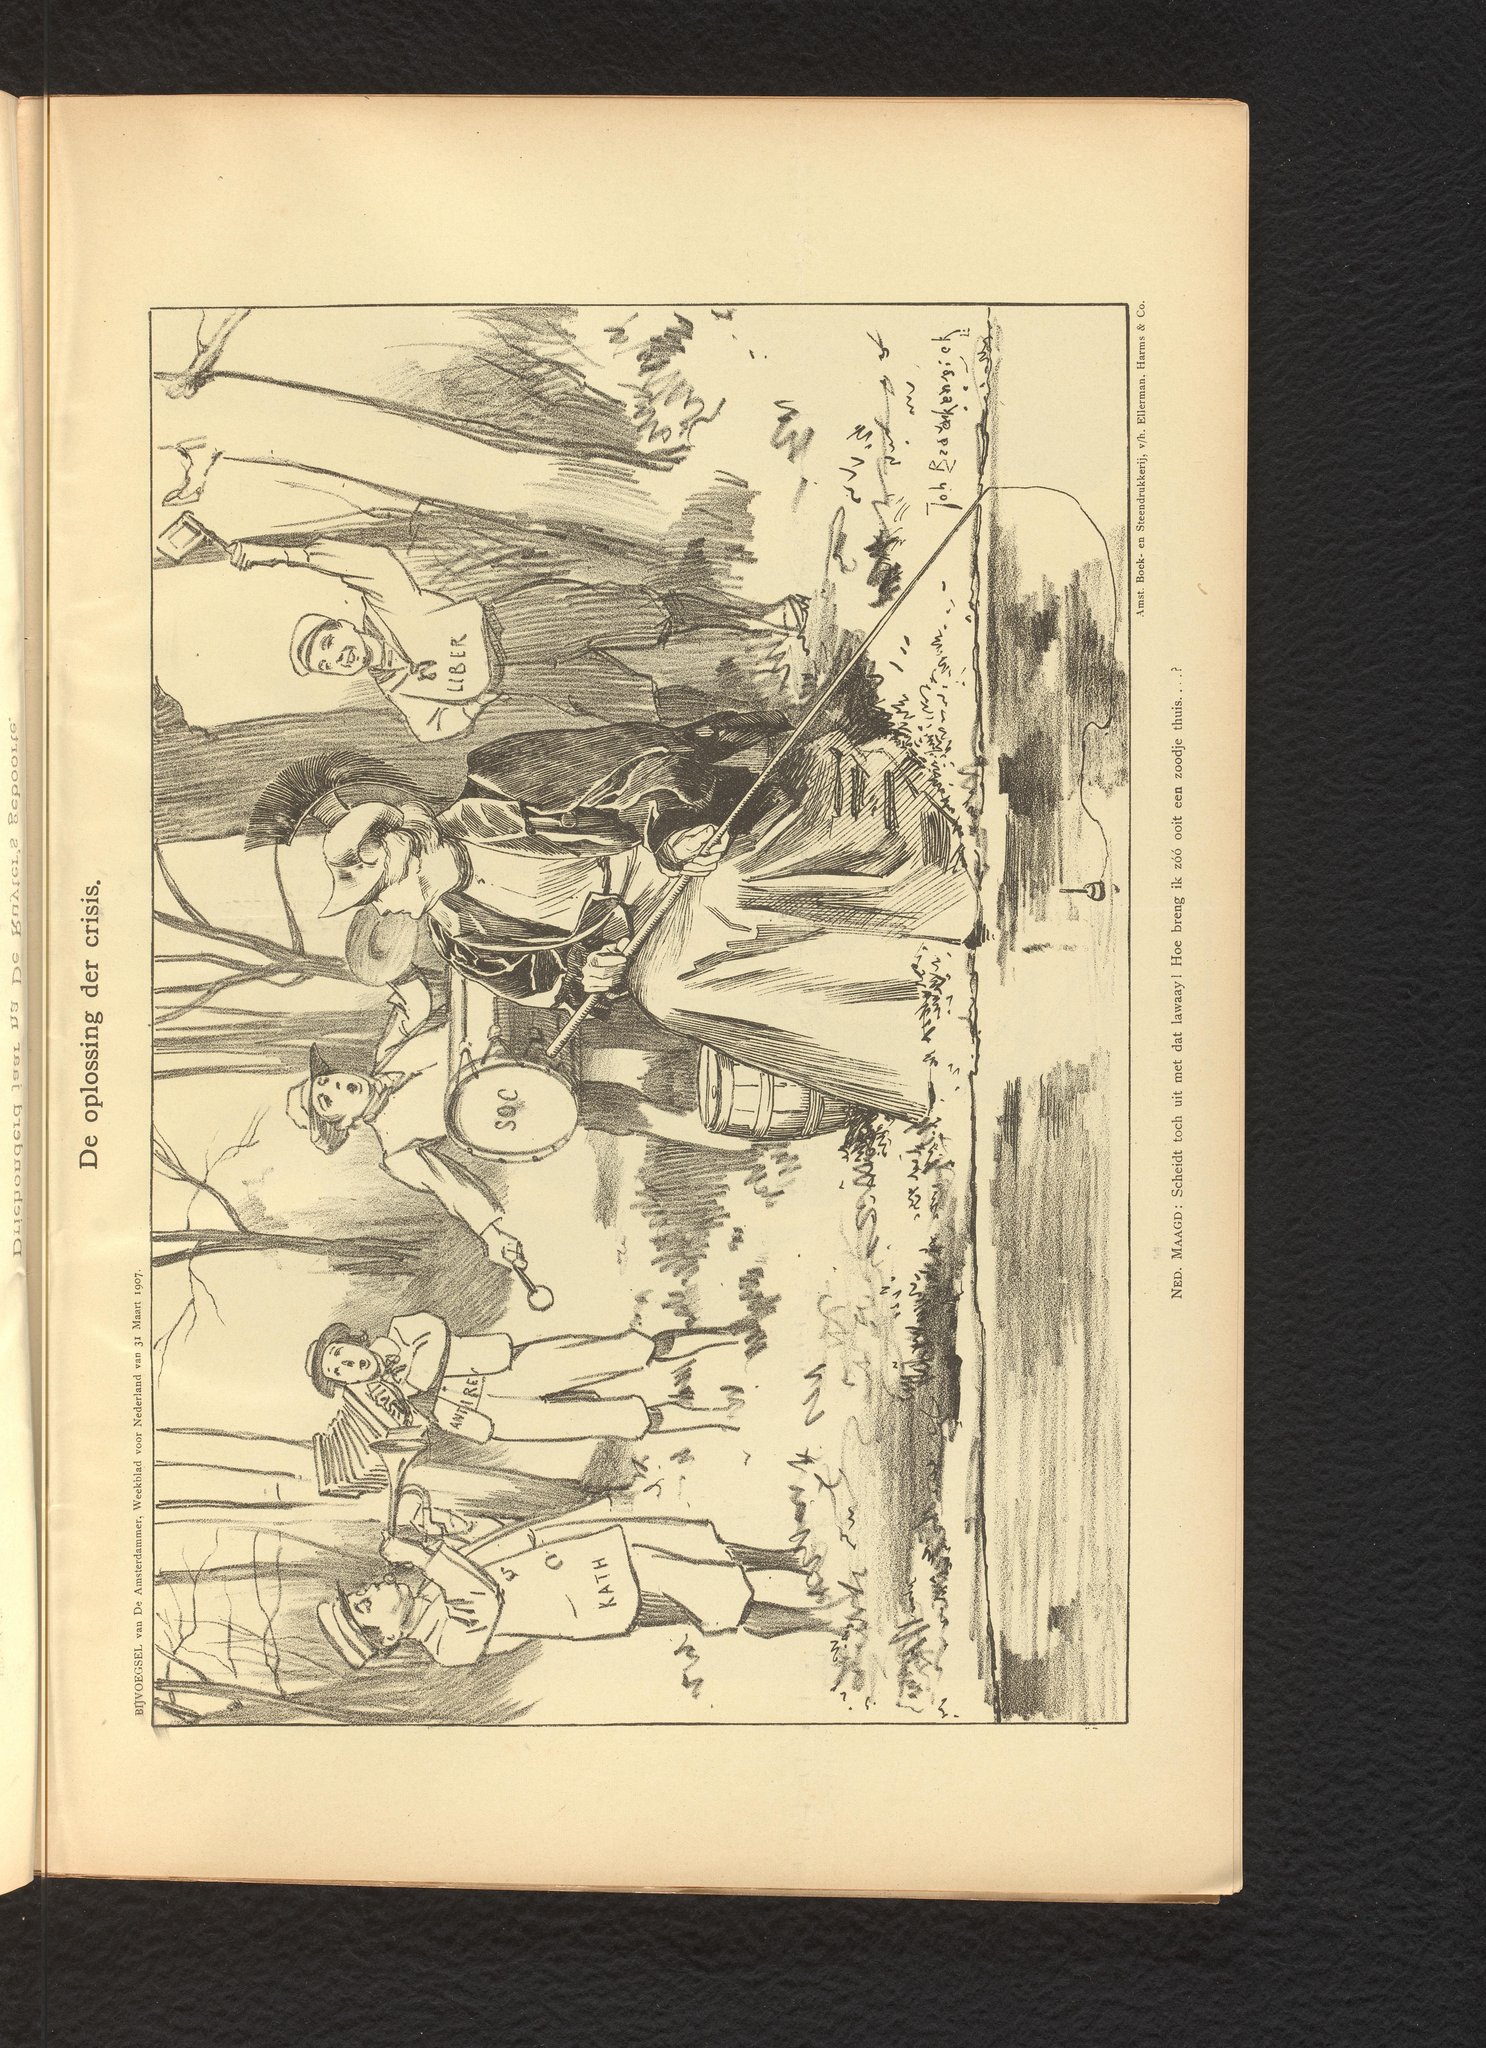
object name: cartoon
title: De oplossing der crisis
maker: johan braakensiek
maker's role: draughtsman, print maker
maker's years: 1858-1940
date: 1907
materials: paper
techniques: lithograph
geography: netherlands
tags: personifications of countries, nations, states, districts, etc., angling, political parties, political caricatures and satires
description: De Nederlandse Maagd wordt bij het vissen aan de waterkant gestoord door knapen, de politieke partijen, die lawaai maken.